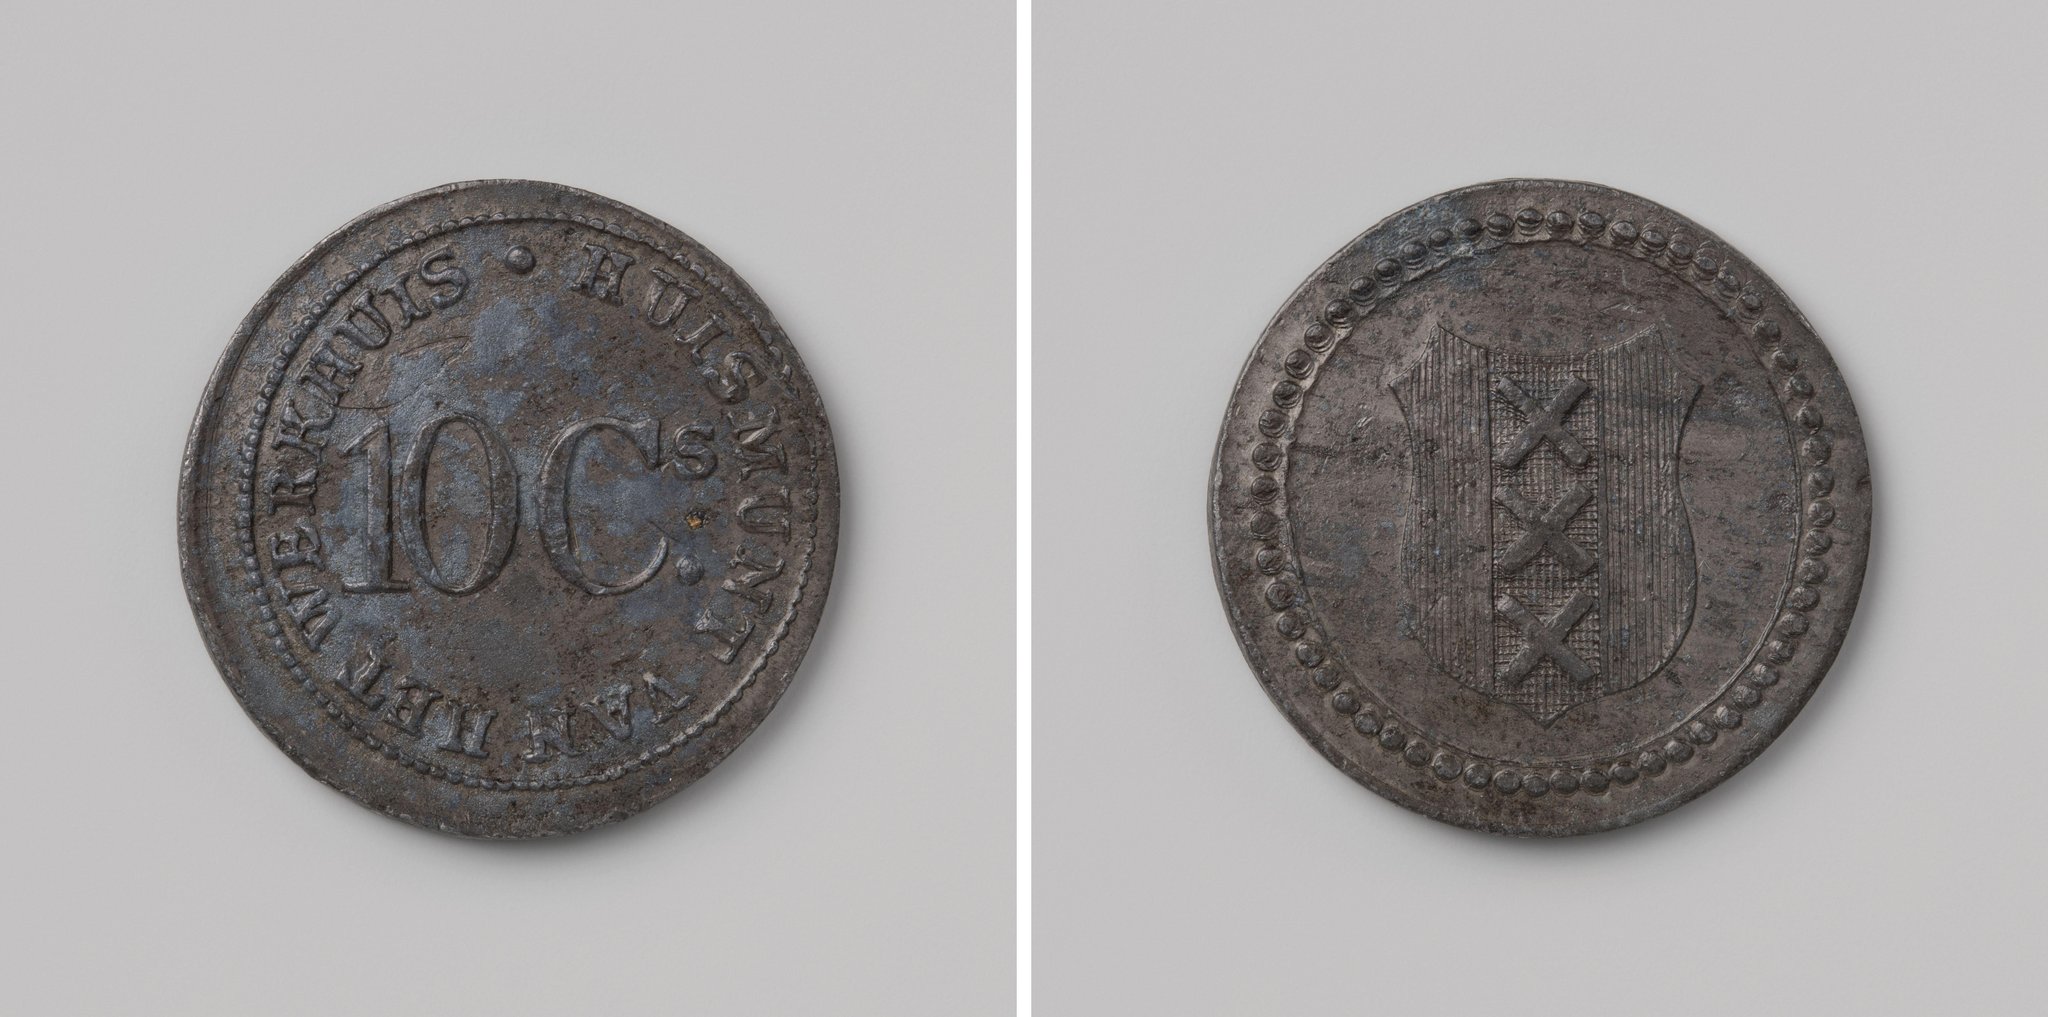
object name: monetary token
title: Huismunt ter waarde van tien cent, van het Werkhuis te Amsterdam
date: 1824-1837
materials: lead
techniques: striking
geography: amsterdam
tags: amsterdam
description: Voorzijde: waardeaanduiding binnen omschrift en parelrand. Keerzijde: wapenschild binnen parelrand